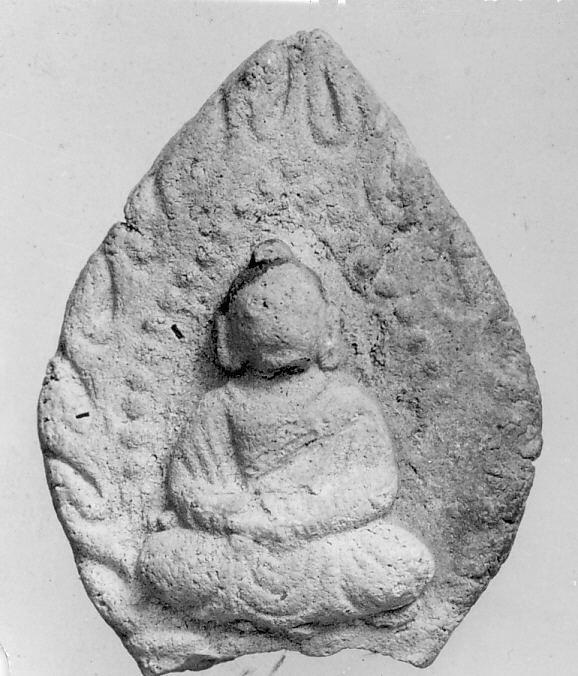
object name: relief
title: Relief of a Buddha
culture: central asian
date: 201-700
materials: plaster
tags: buddhism,buddha